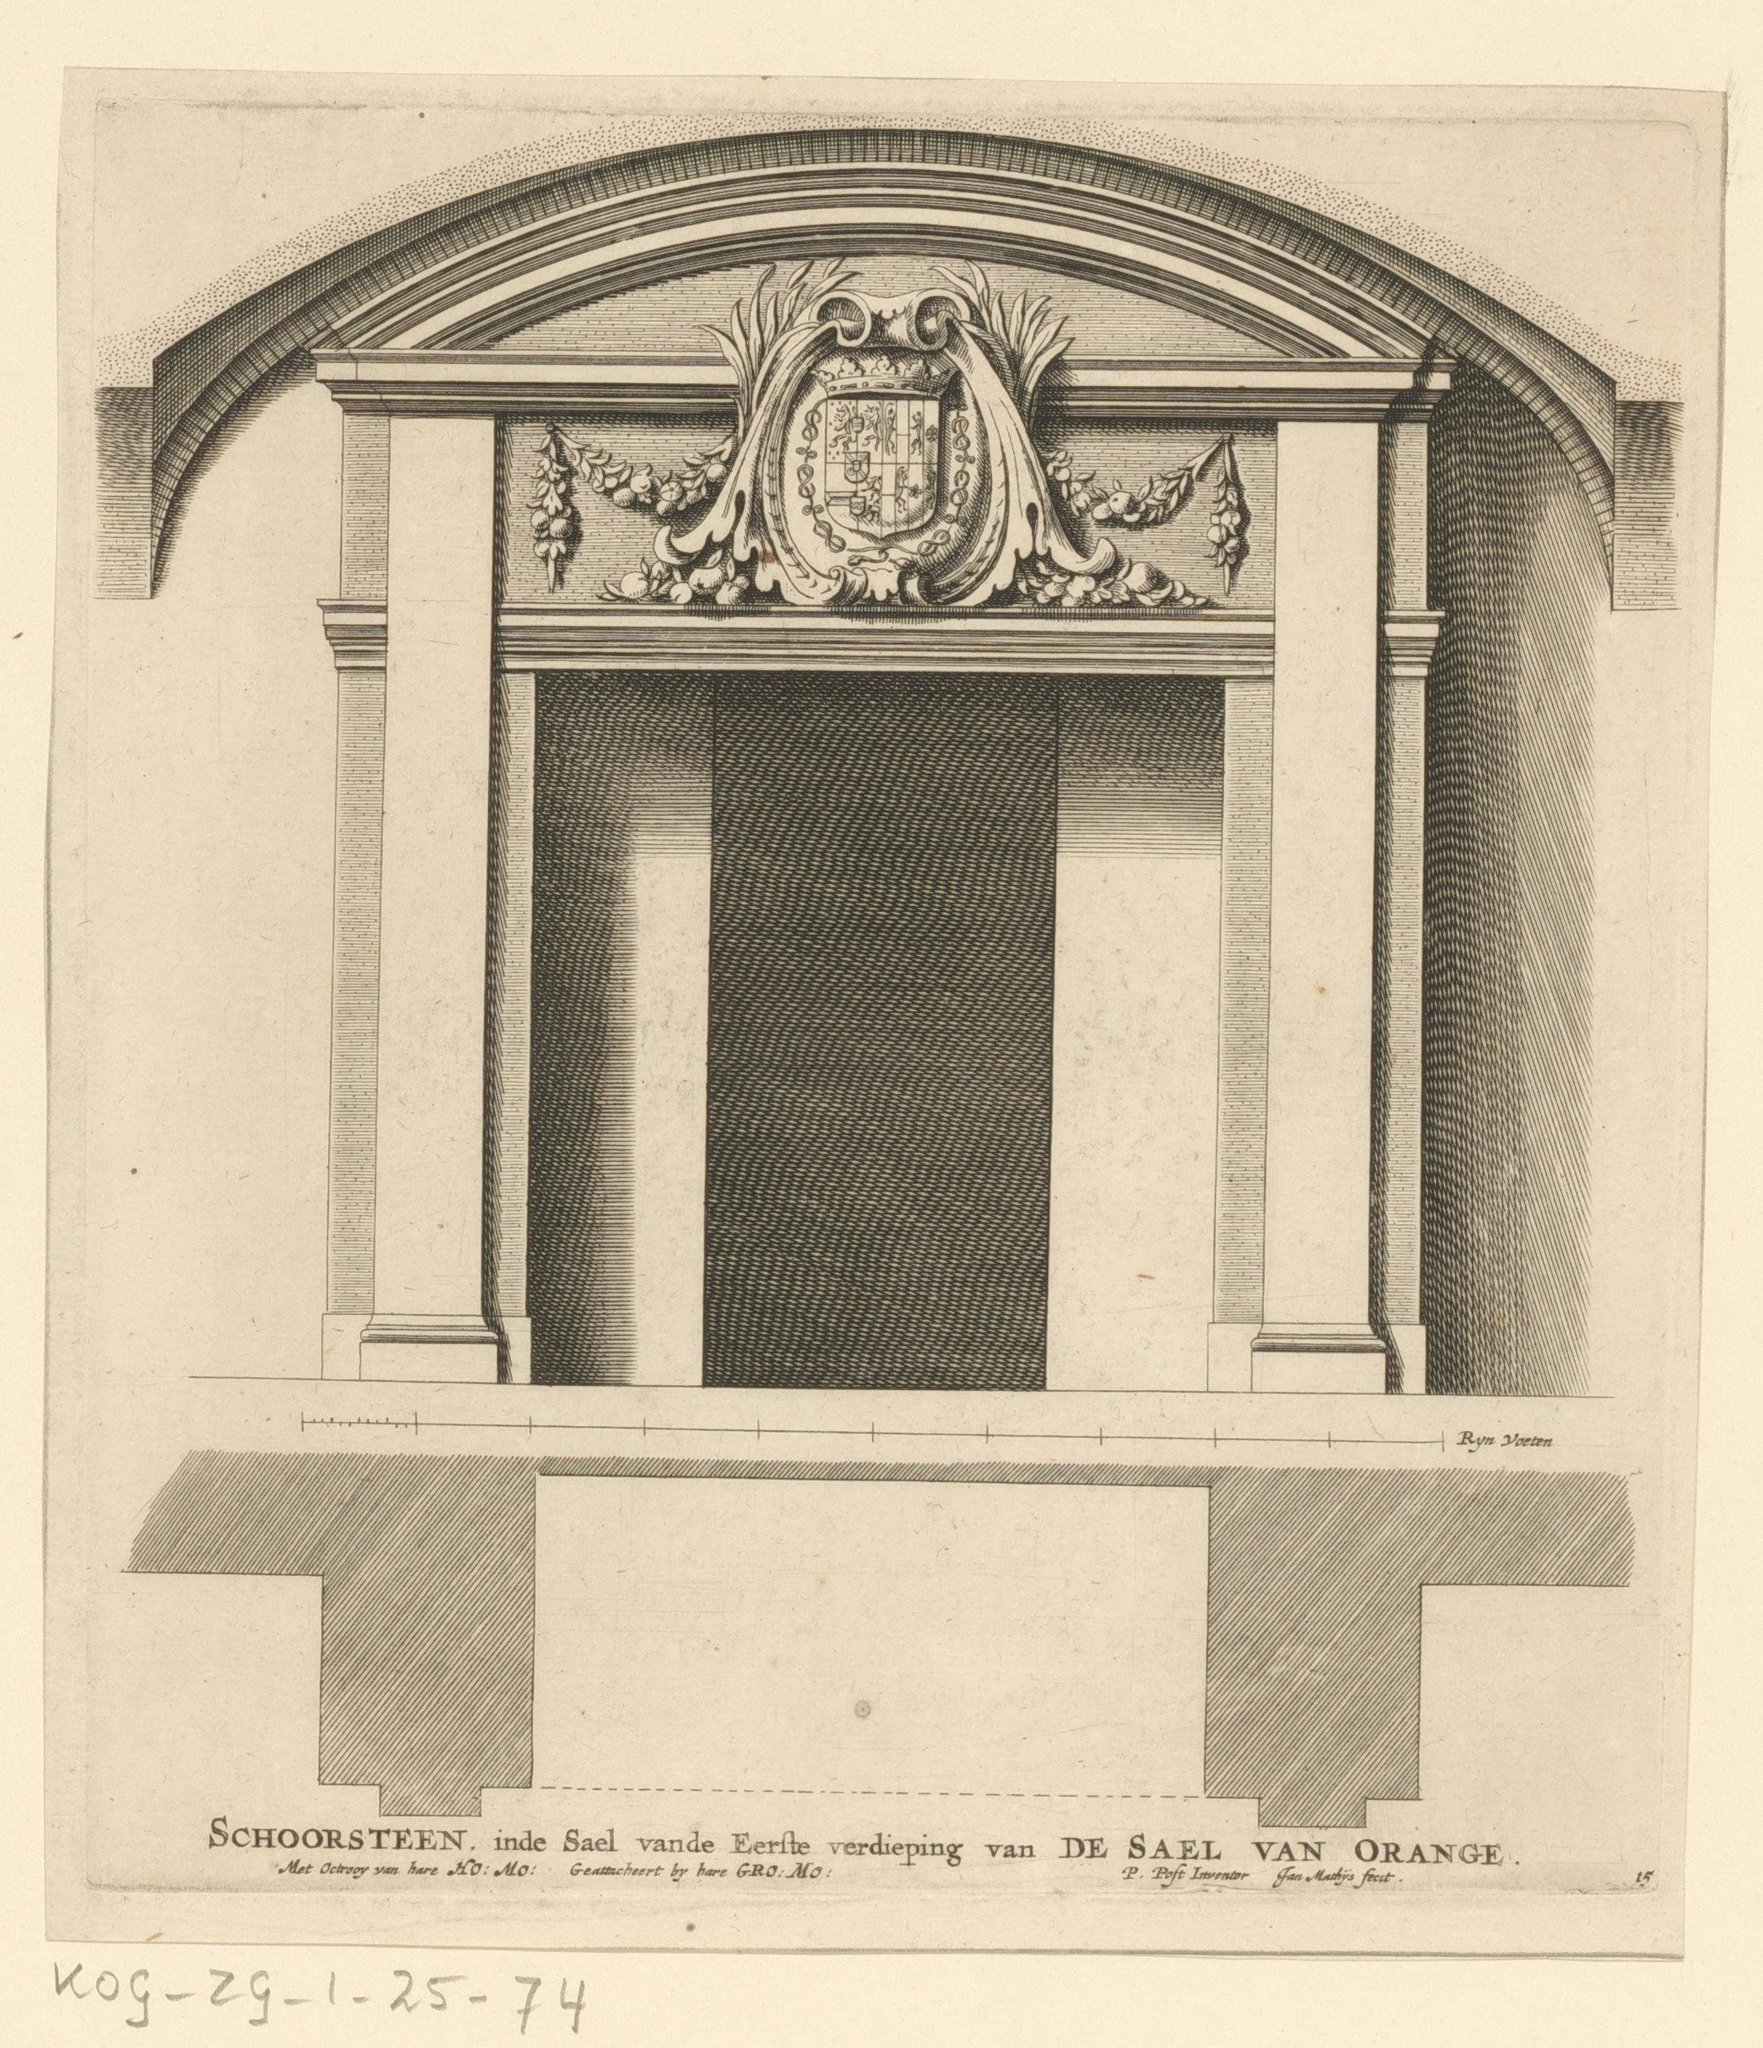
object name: ornament print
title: Schouw van de eerste verdieping van Paleis Huis ten Bosch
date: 1669-1706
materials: paper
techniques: engraving, etching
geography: amsterdam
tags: chimney, chimney ornaments, chimney-piece, mantelpiece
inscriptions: stamp:, collector's mark: Lugt 1641, : ‘Met Octrooy van hare HO: MO: Geattacheert bij hare GRO: MO:’, collector's mark: Lugt 1641a, stamp:, stamp:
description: Titelprent is onderdeel van een serie bestaande uit een titelprent en 22 vervolg prenten. De serie is voor het eerst uitgegeven door Pieter Jansz. Post in Den Haag of Rotterdam. De huidige (tweede staat) is uitgegeven door Frederik de Wit tussen 1669 en 1706. De volgorde van de prenten is in deze serie veranderd. De prenten zijn een derde keer uitgegeven door Pieter van der Aa in 1715 te Leiden. Hier is de volgorde wederom aangepast.